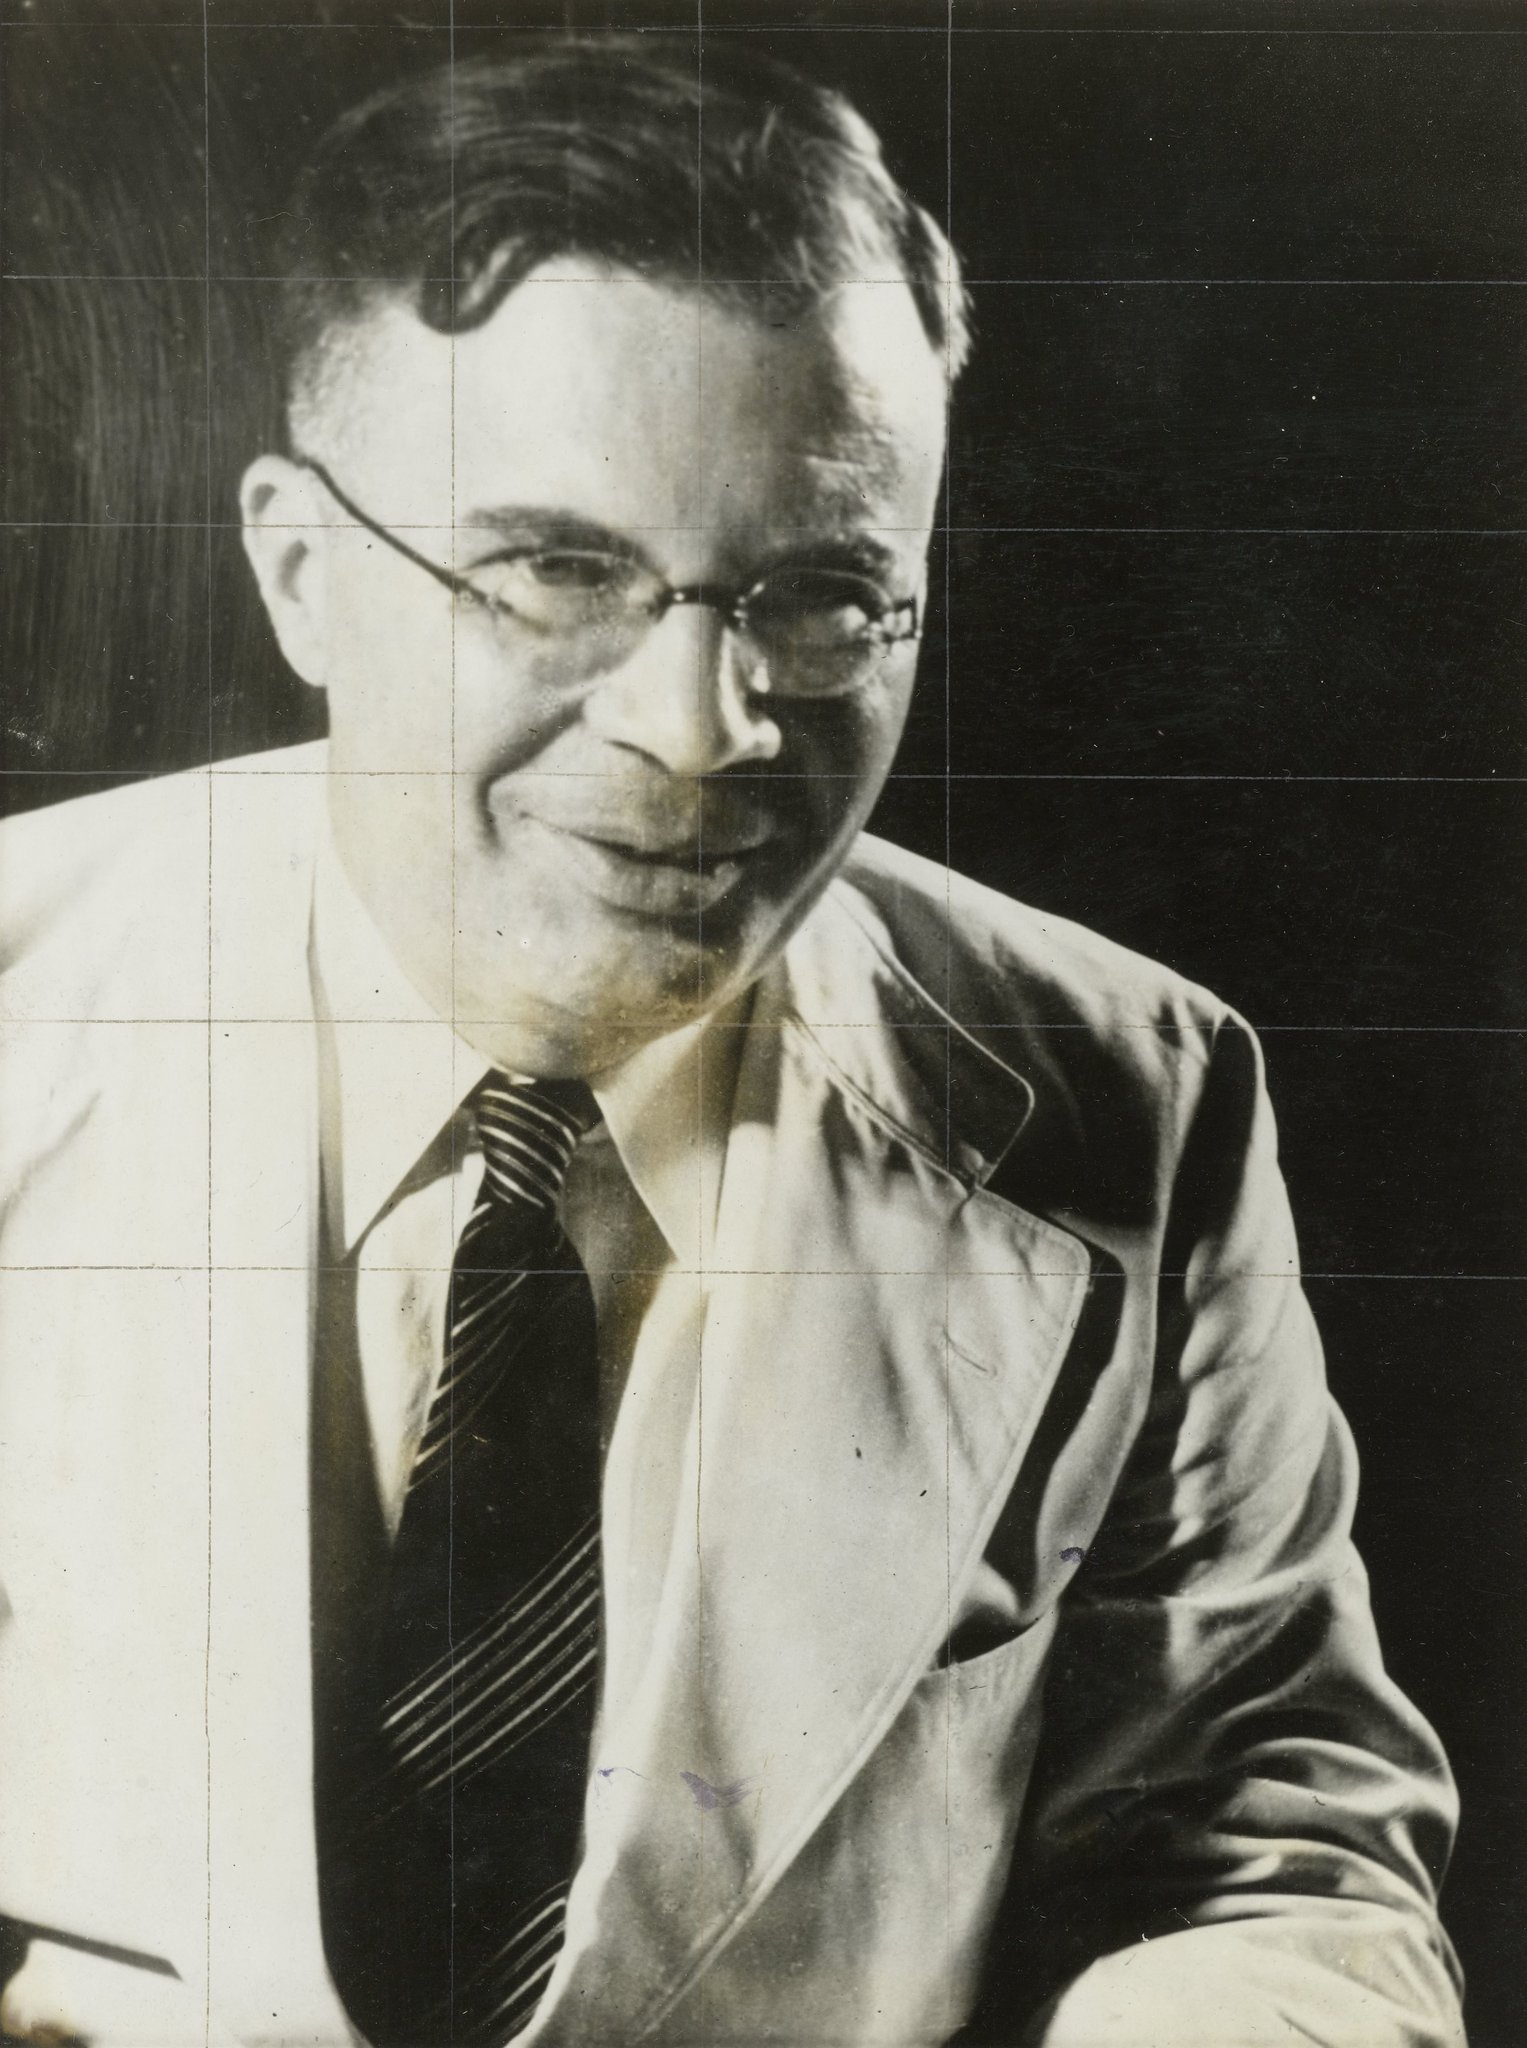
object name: photograph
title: Portret van Hubertus J. van Mook, minister van koloniën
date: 1940-1945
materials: photographic support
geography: london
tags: france, hubertus johannes van mook, london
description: Portret van Hubertus J. van Mook (1894-1965), minister van koloniën. Na de Japanse inval vluchtte Van Mook uit Nederlands-Indië naar Australië en ging van daar naar Londen. In Londen werd hij de Nederlandse minister van Koloniën. Het lijnennet op de foto is aangebracht door kunstenaar Cor Visser.